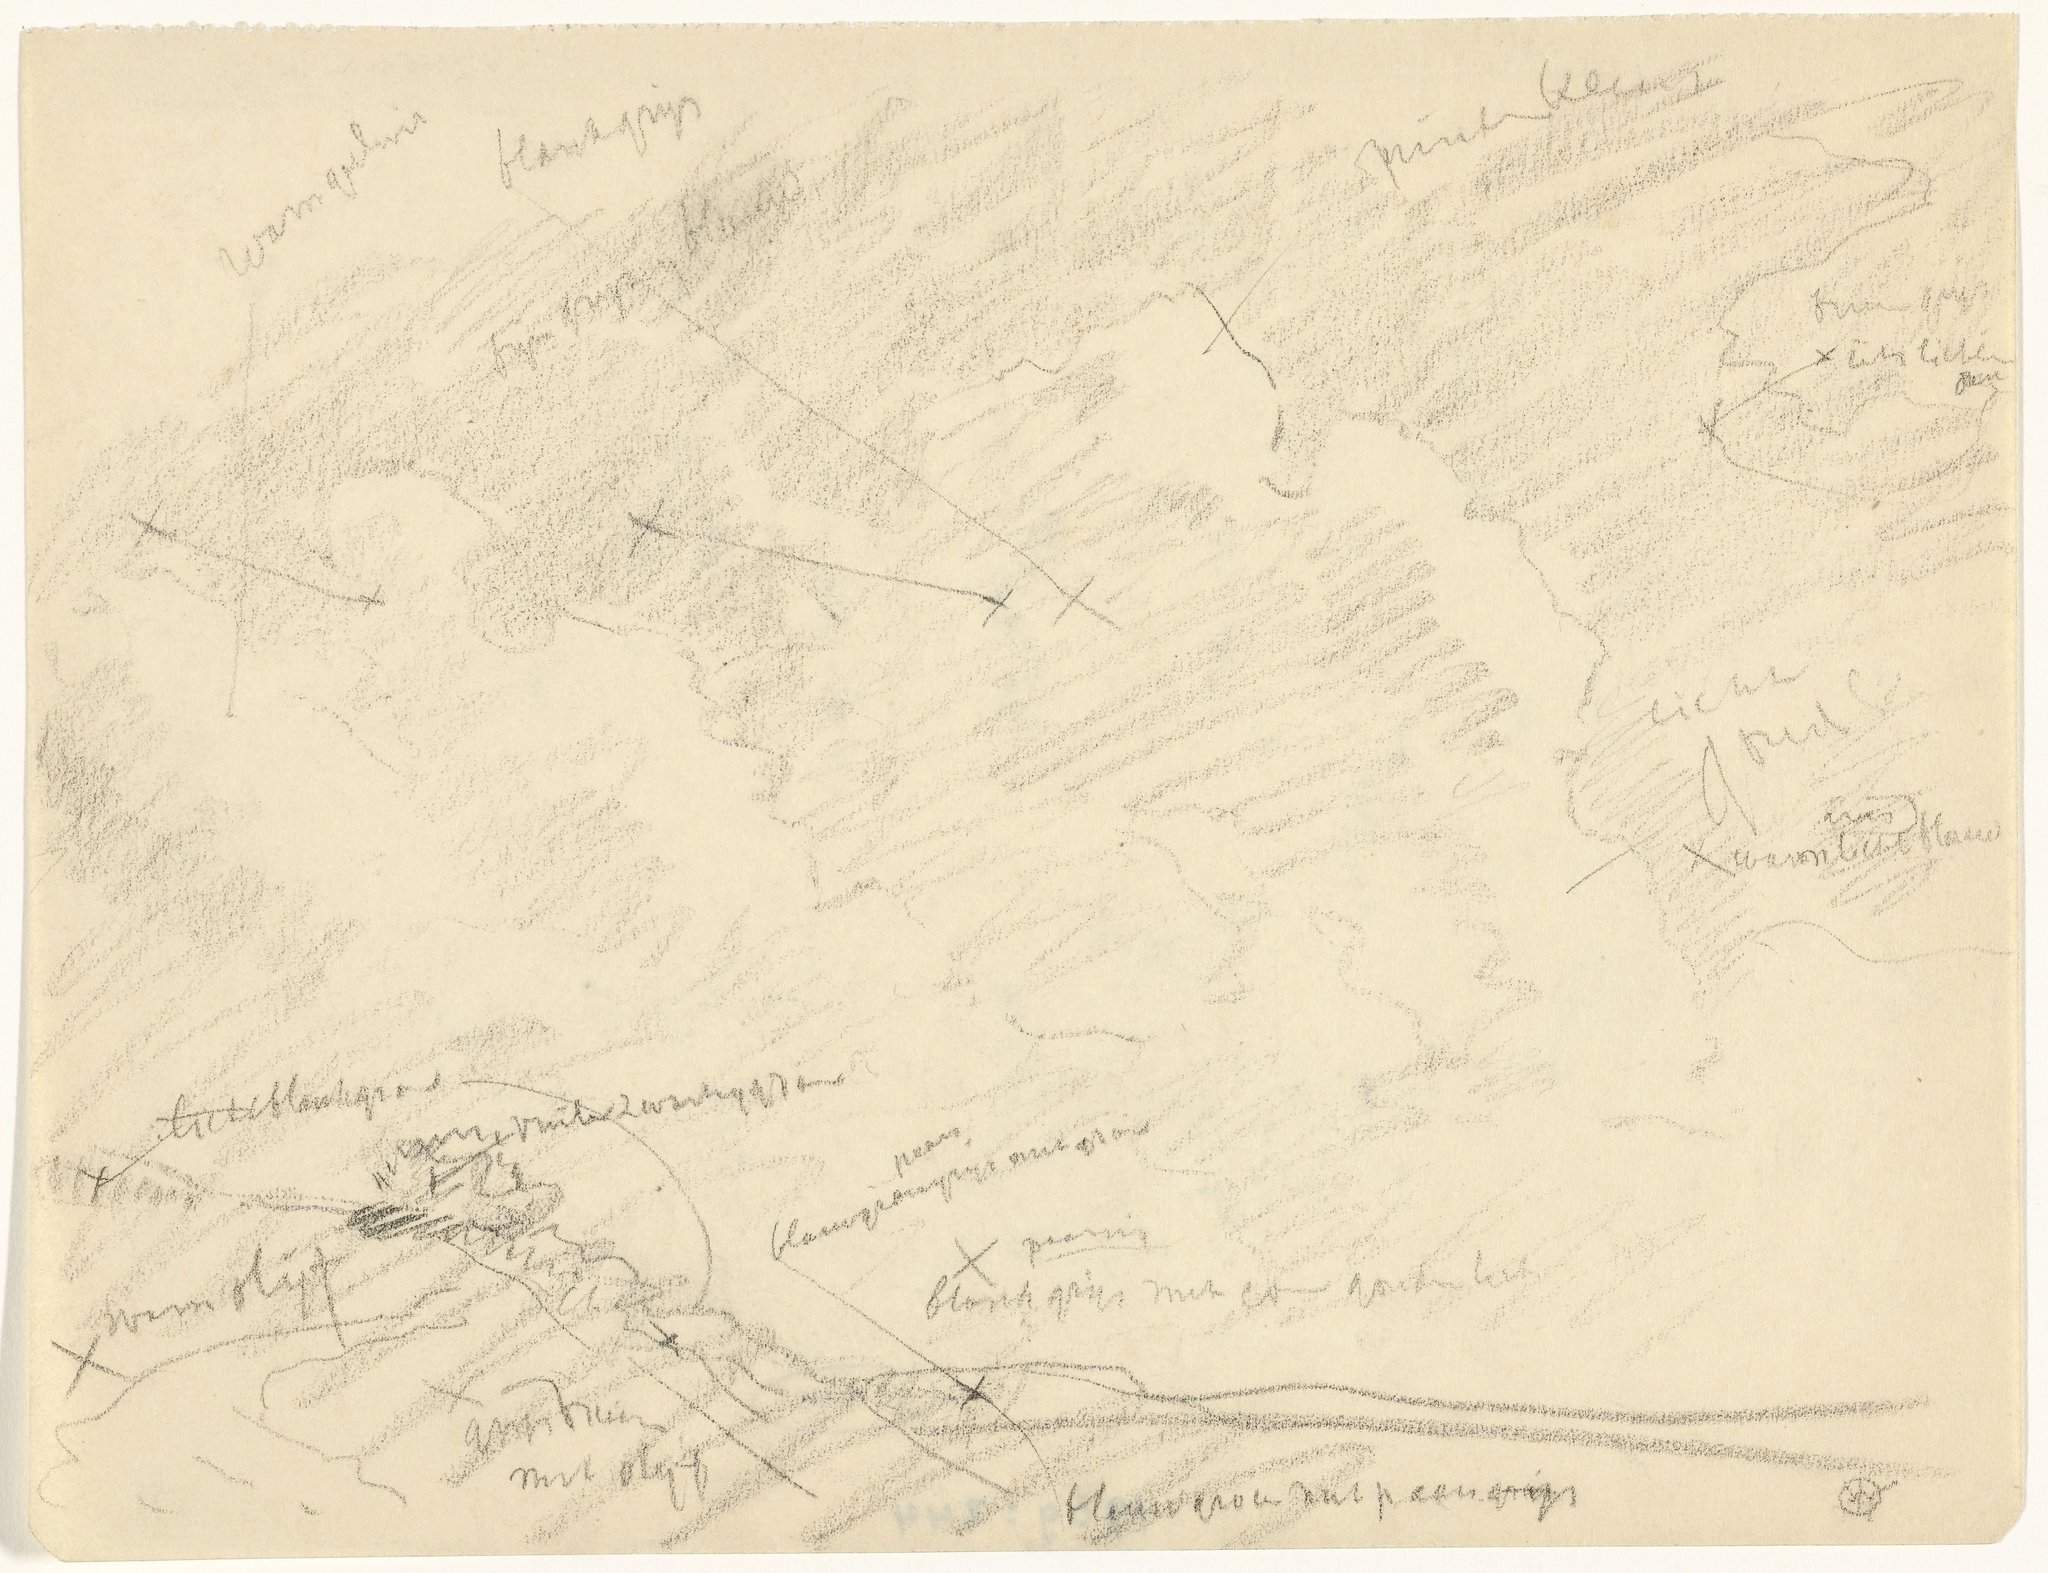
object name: drawing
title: Wolkenlucht boven heuvels, met kleurnotities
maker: gerrit willem dijsselhof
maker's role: designer, draughtsman, print maker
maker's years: 1866-1924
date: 1876-1924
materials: chalk, paper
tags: clouds, firmament, sky